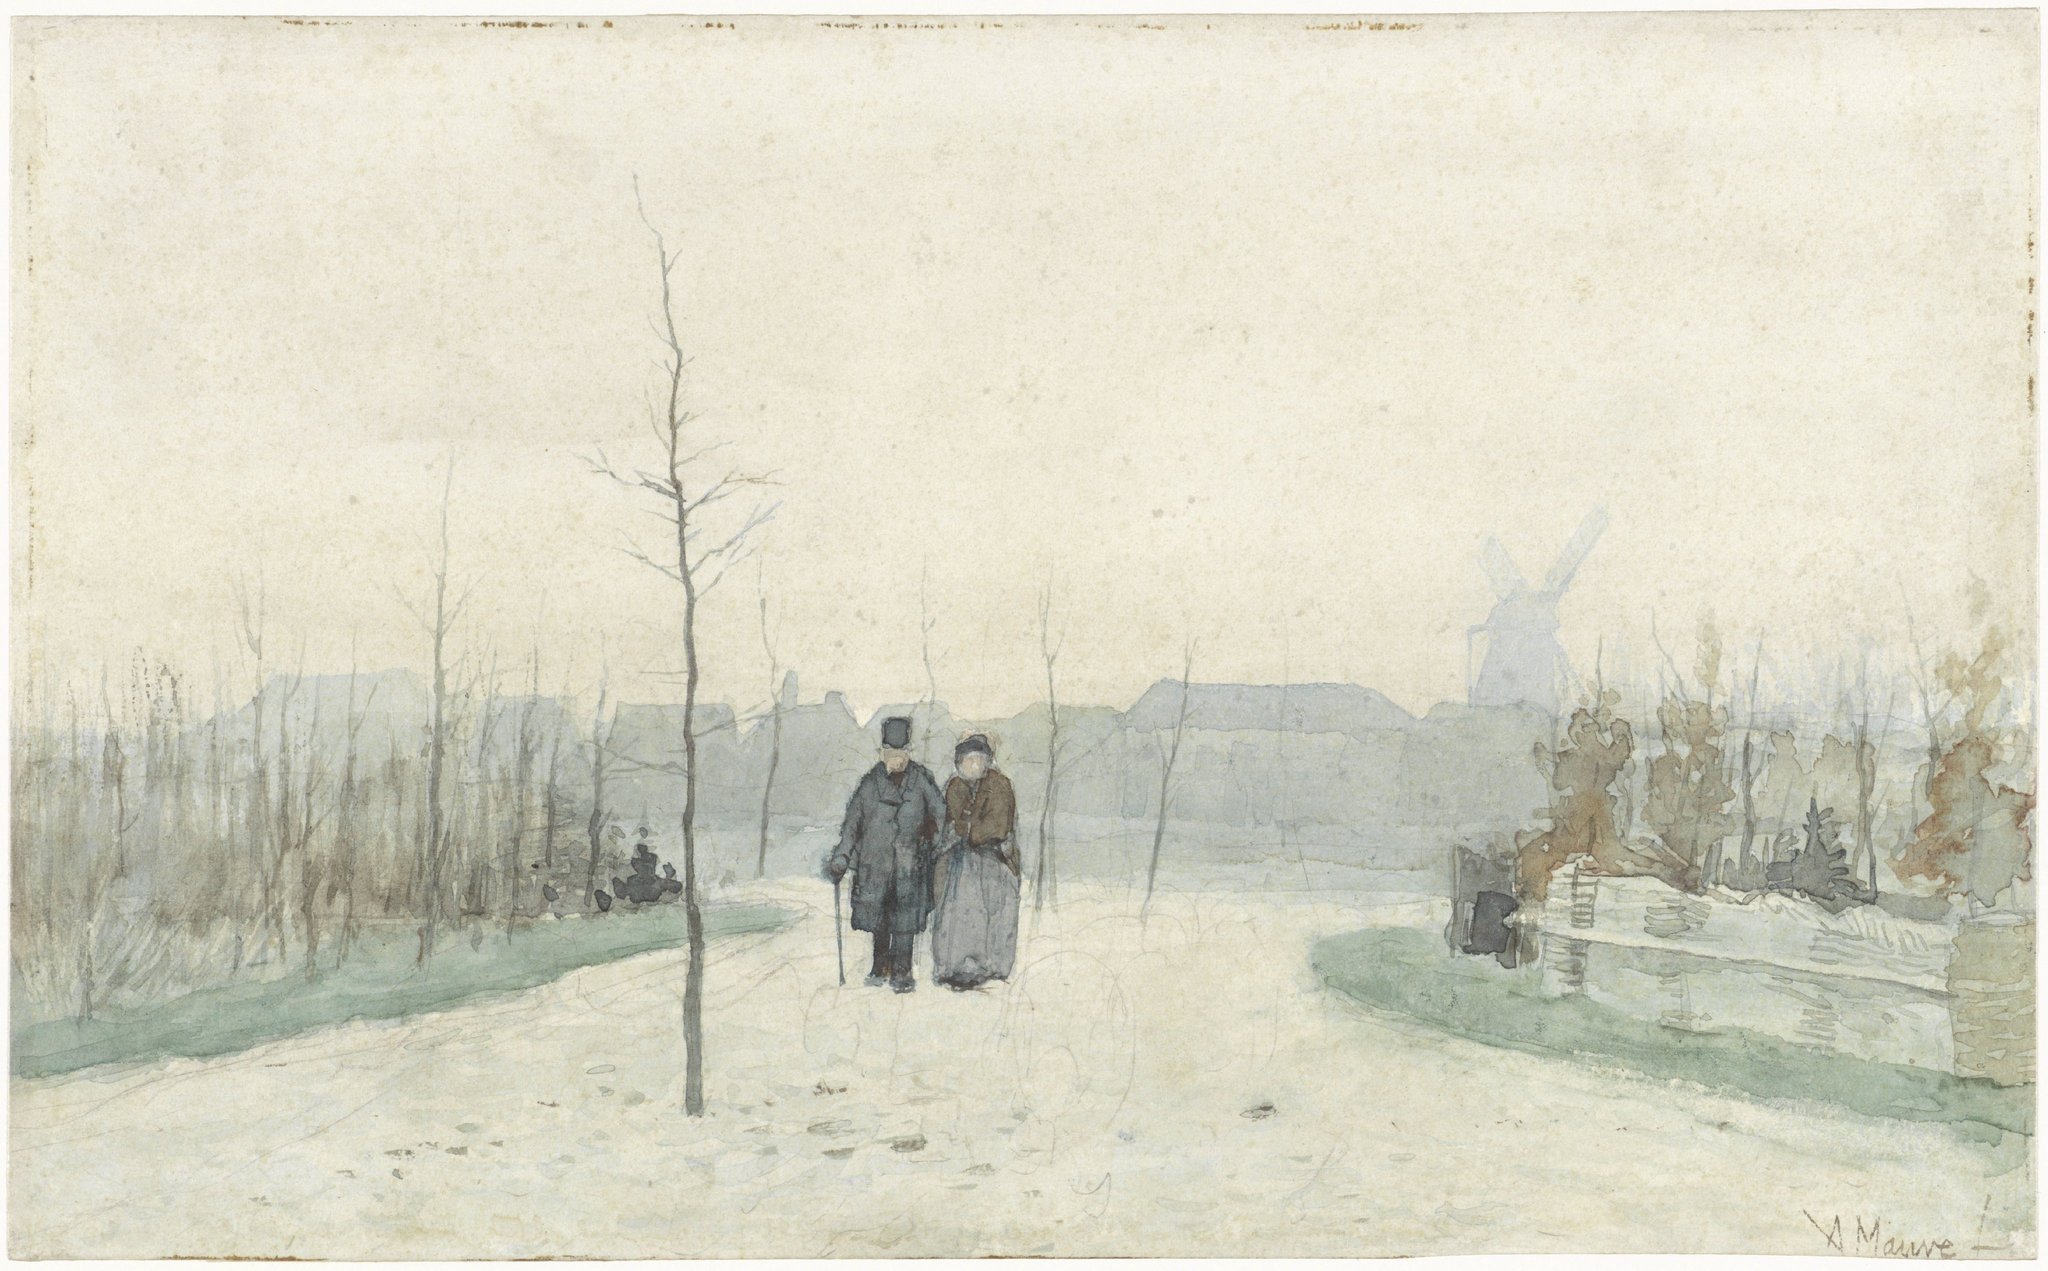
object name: watercolor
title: Oud paar in een nieuw aangelegd park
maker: anton mauve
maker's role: draughtsman, painter, print maker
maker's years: 1838-1888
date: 1848-1888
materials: paper, pencil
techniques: brush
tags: public gardens, park